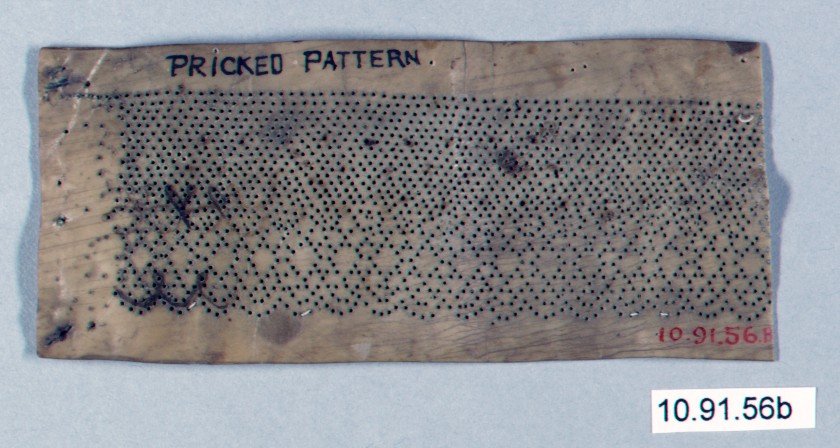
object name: pricking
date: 1801-1900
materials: parchment